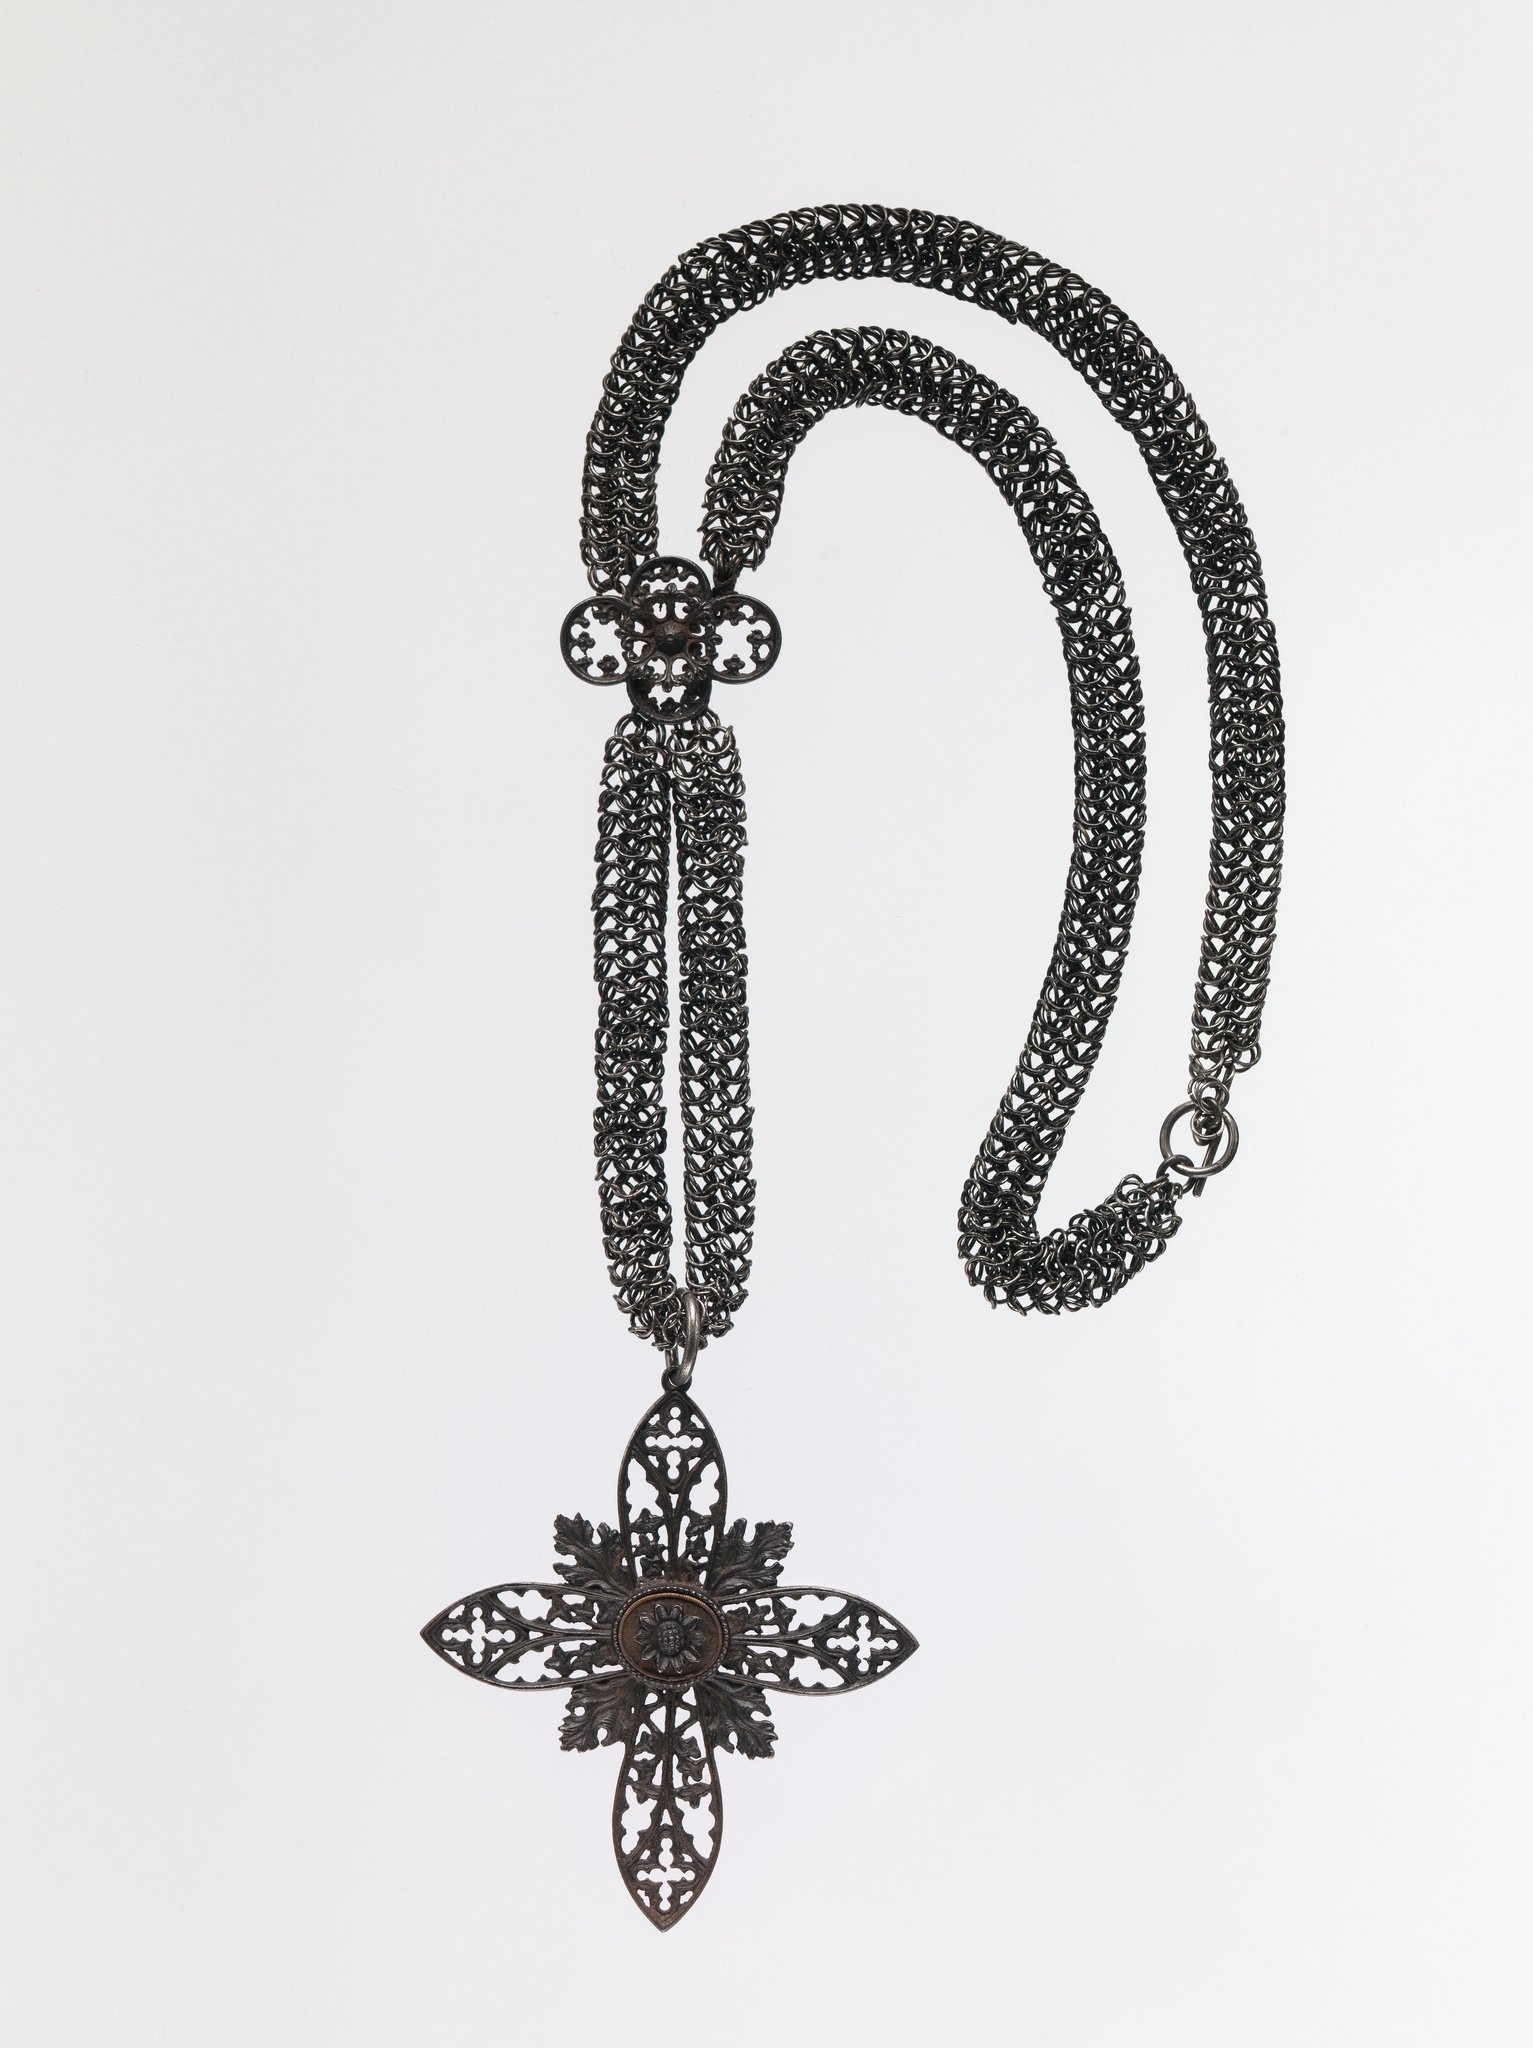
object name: necklace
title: Berlin ironwork necklace with cross pendant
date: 1830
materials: iron